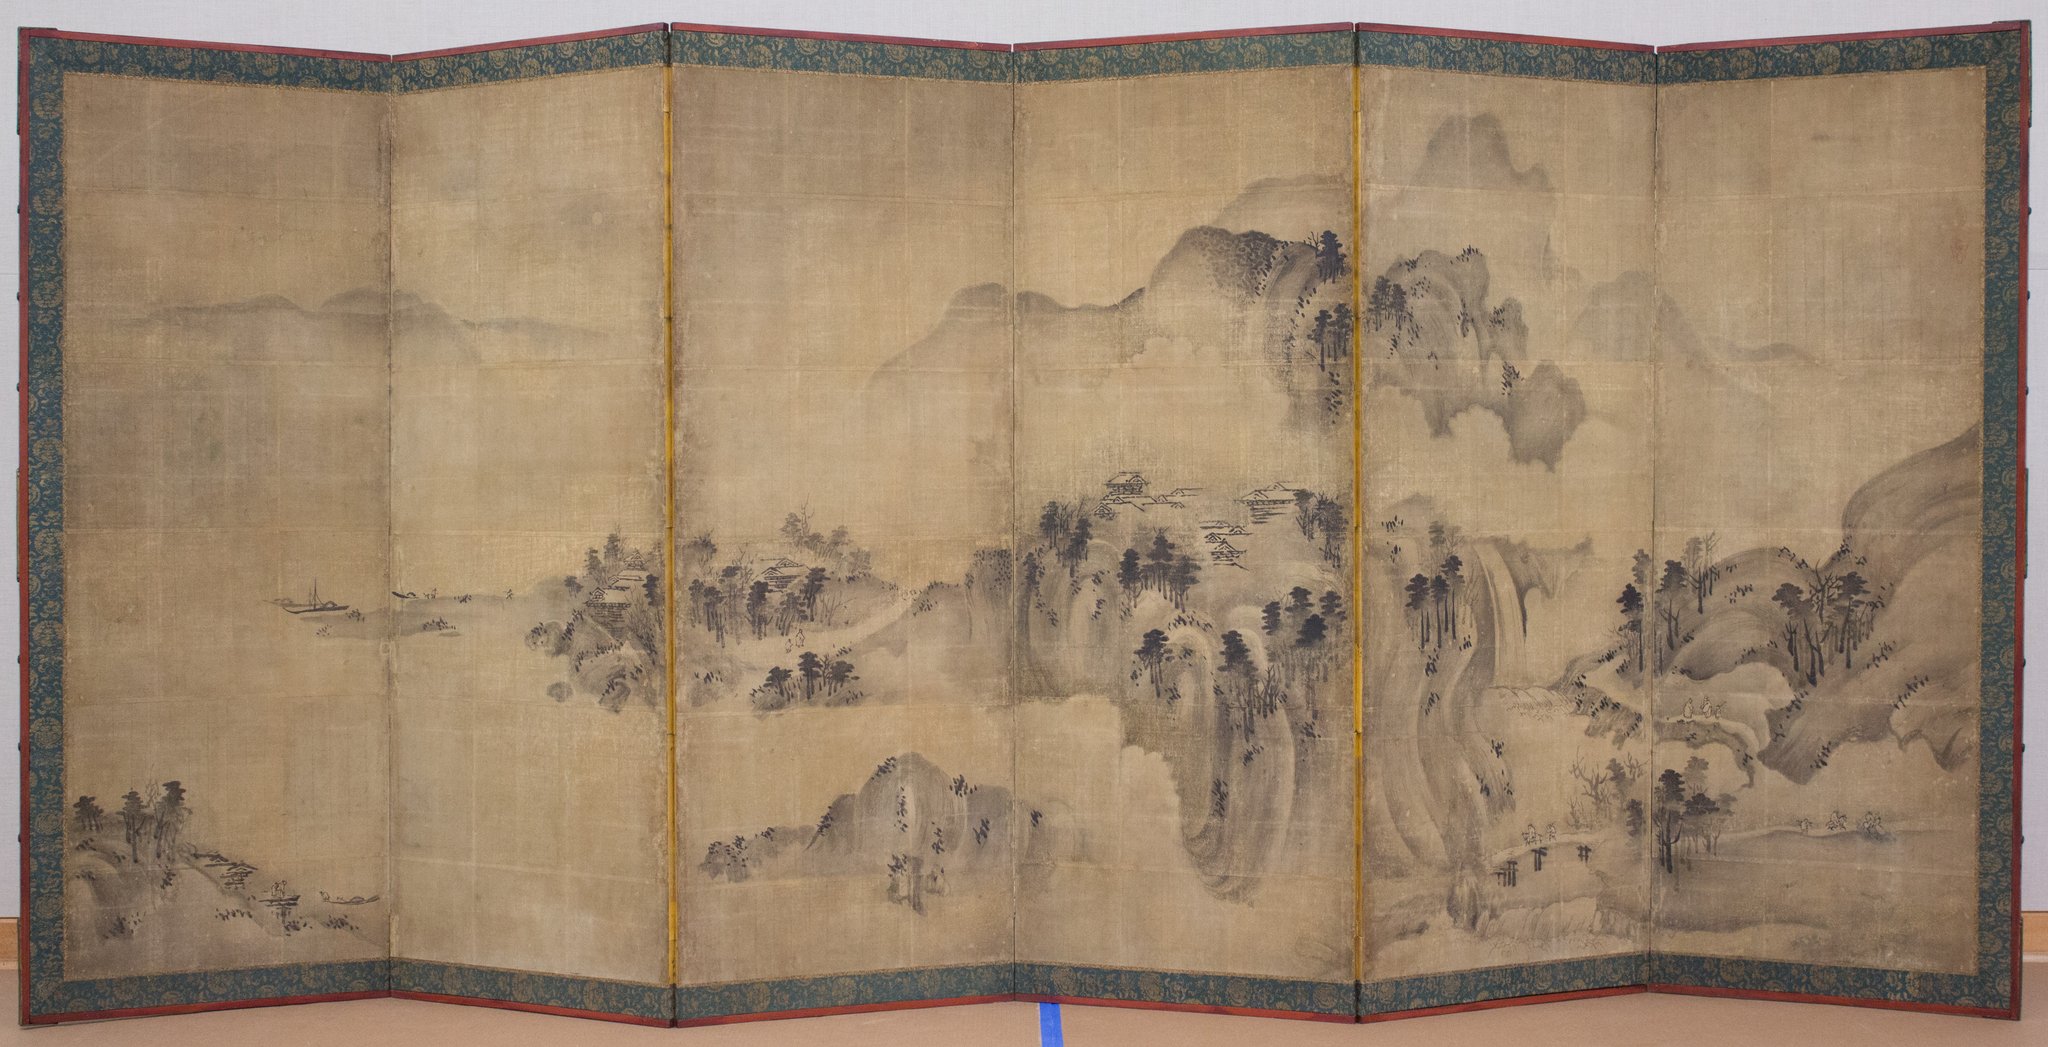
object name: screen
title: Landscape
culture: japanese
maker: sesson shūkei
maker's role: artist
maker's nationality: japanese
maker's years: 1504-1589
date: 1501-1600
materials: ink, panel, paper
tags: mountains,landscapes